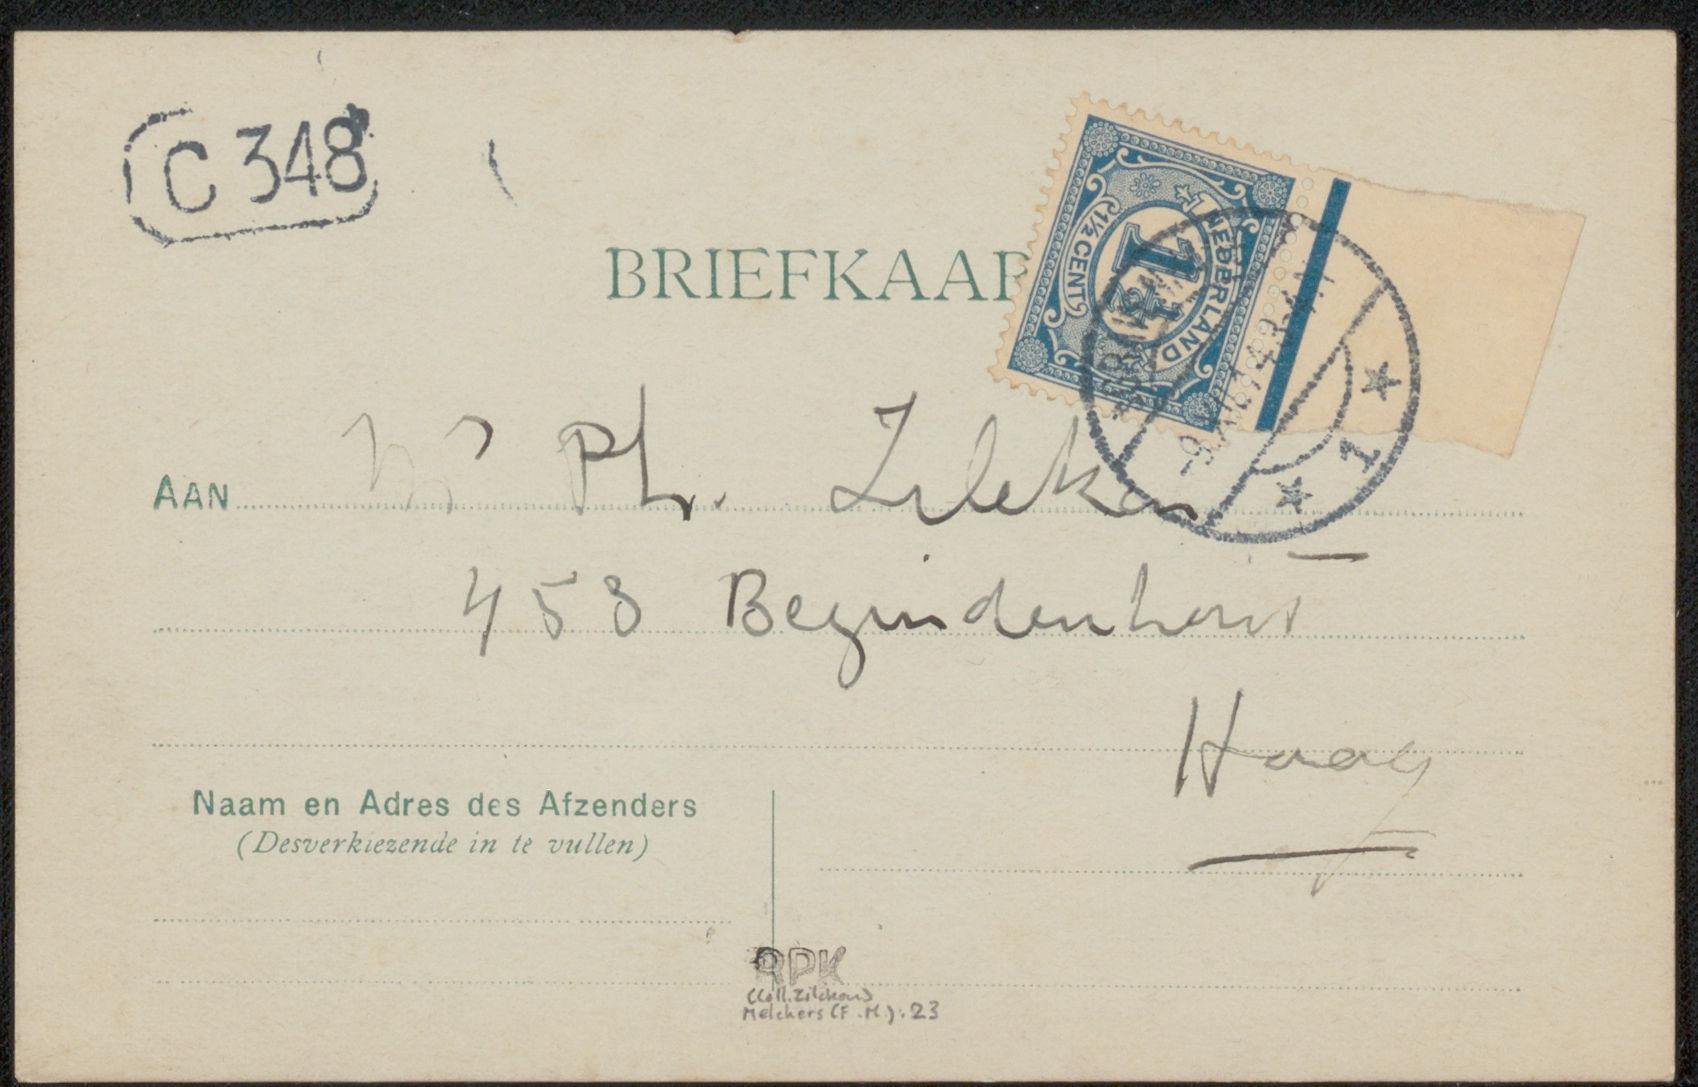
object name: postcard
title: Briefkaart aan Philip Zilcken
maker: franz melchers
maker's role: draughtsman, painter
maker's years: 1868-1944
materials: cardboard, ink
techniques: pen, writing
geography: the hague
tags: painter, draughtsman, philip zilcken, anonymous historical person portrayed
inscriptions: collector's mark: ‘RPK’